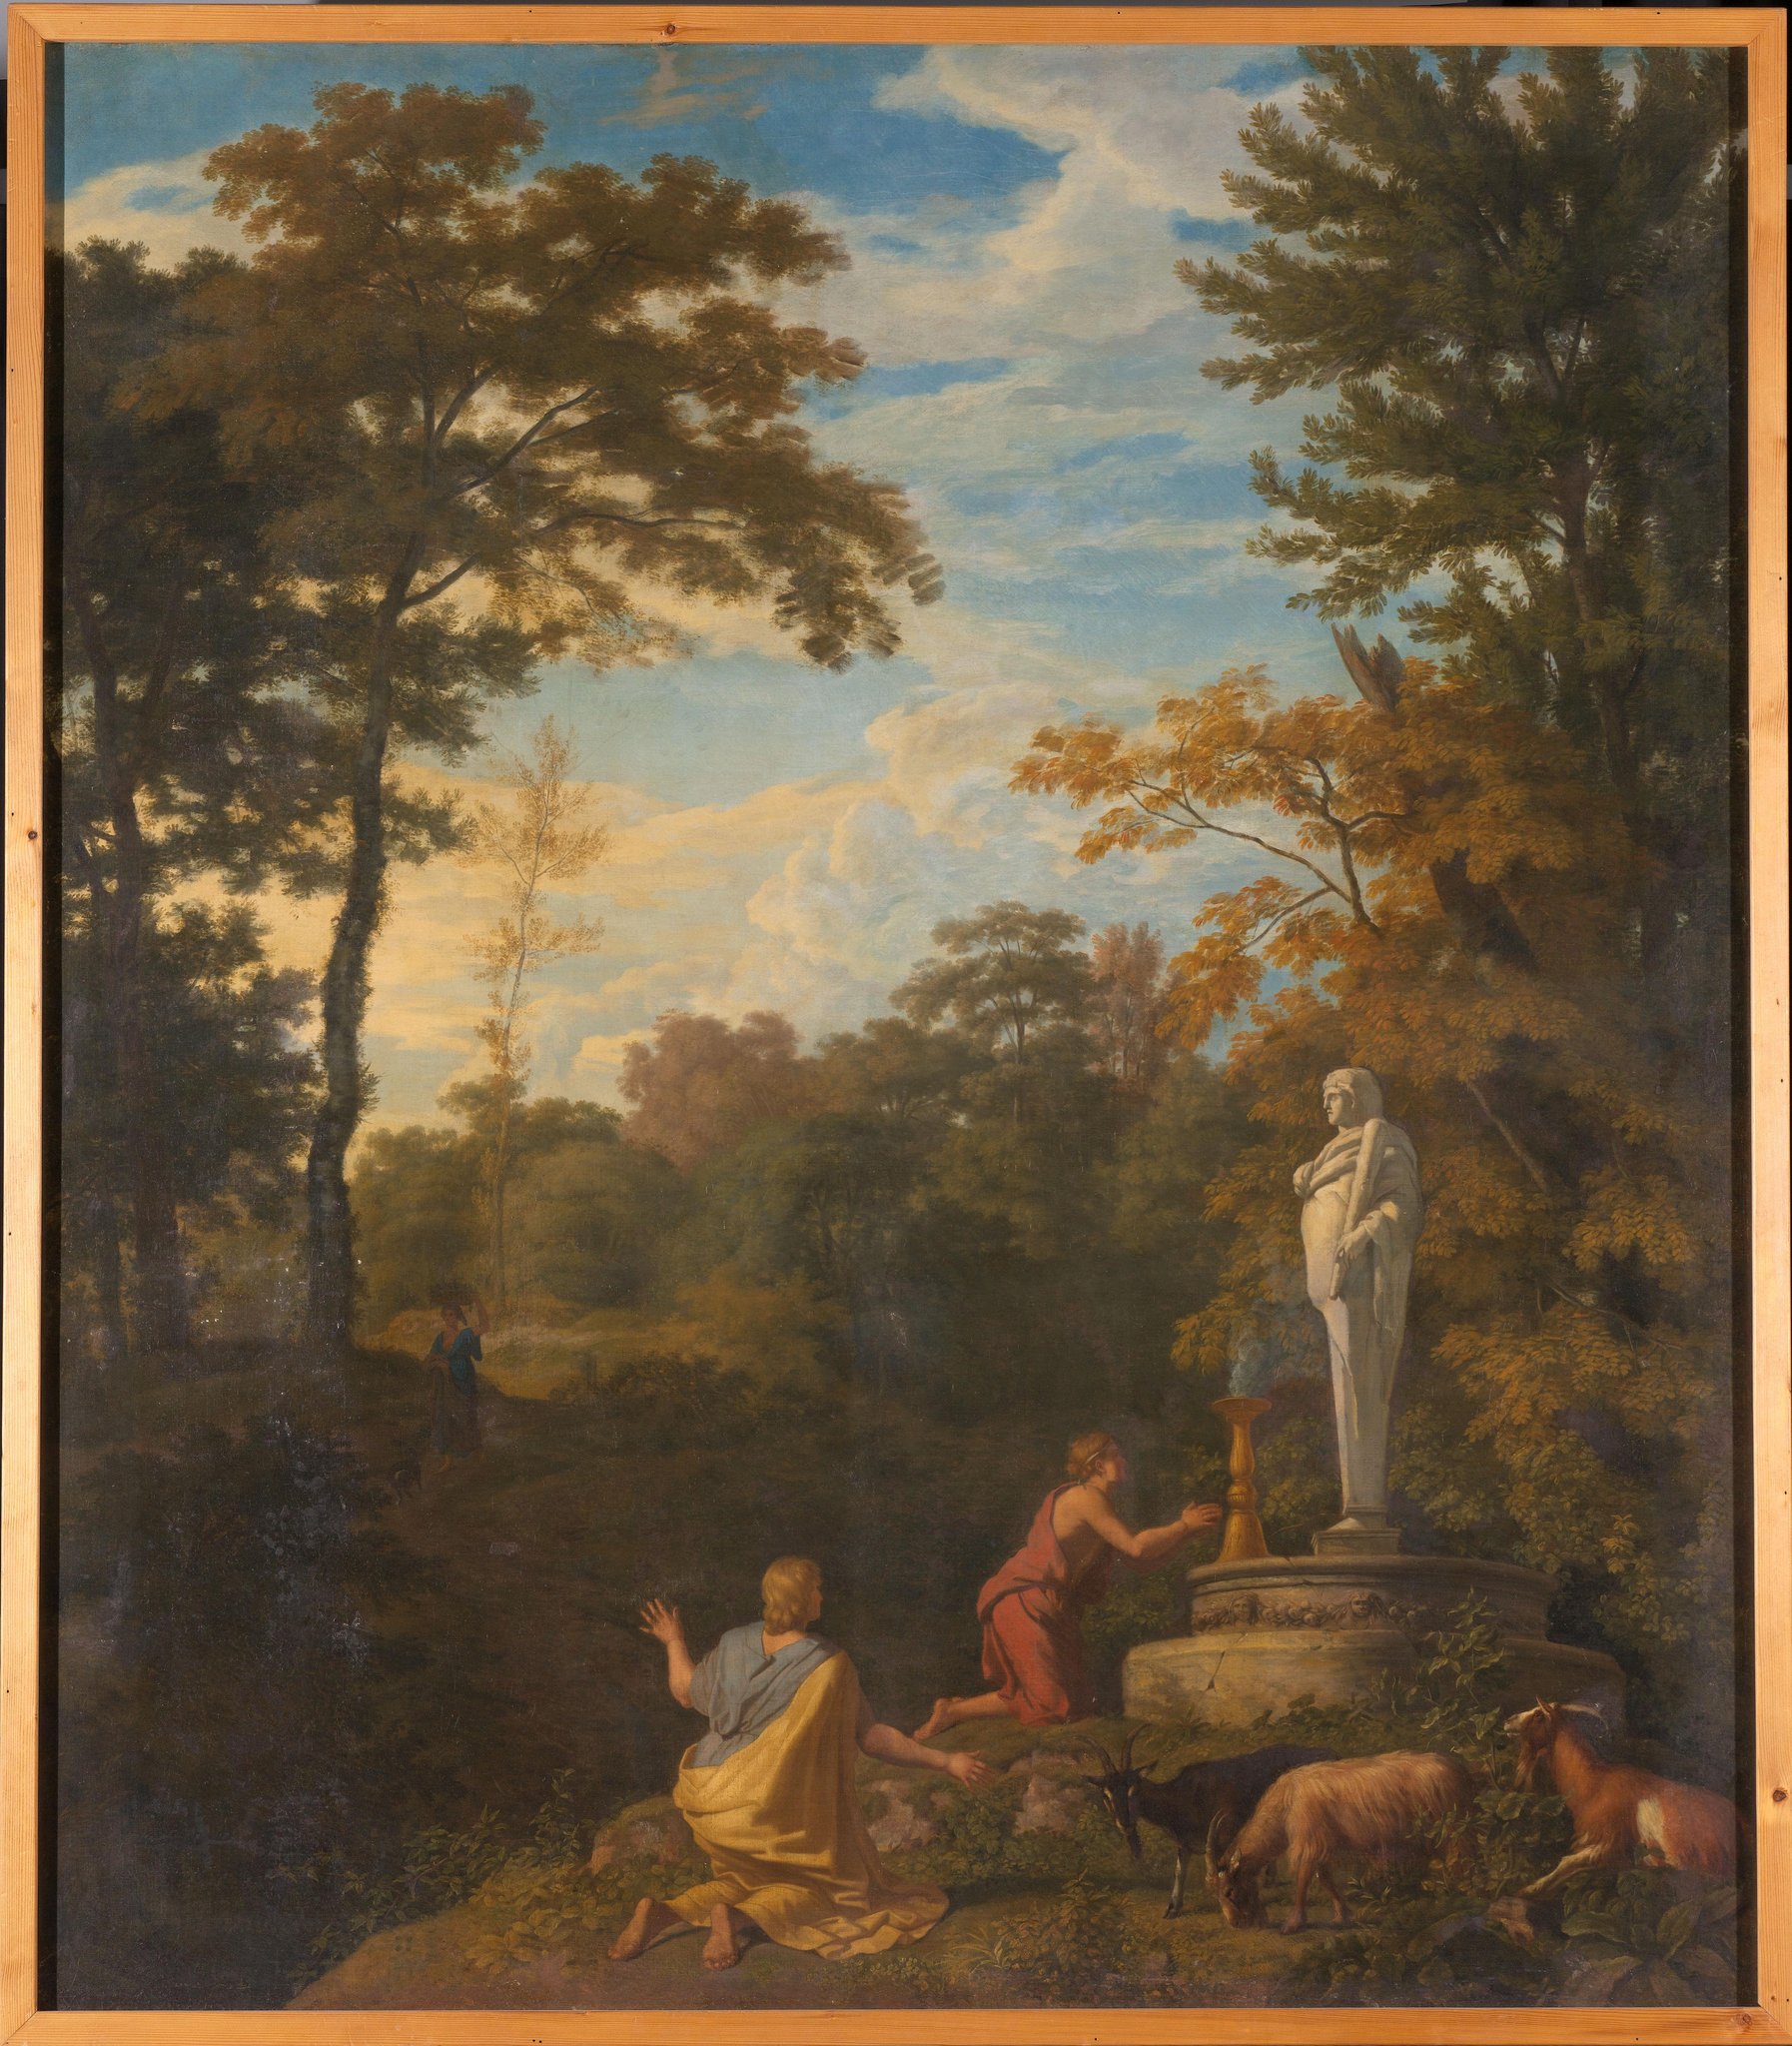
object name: mural painting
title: Arcadian Landscape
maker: johannes glauber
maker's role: draughtsman, painter, print maker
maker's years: 1646-1726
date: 1680-1726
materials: canvas, oil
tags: pastorals, arcadian scenes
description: Arcadisch landschap met twee figuren knielend in aanbidding bij een standbeeld van een man met een knots op een altaar in het bos. Rechts een kudde geiten.